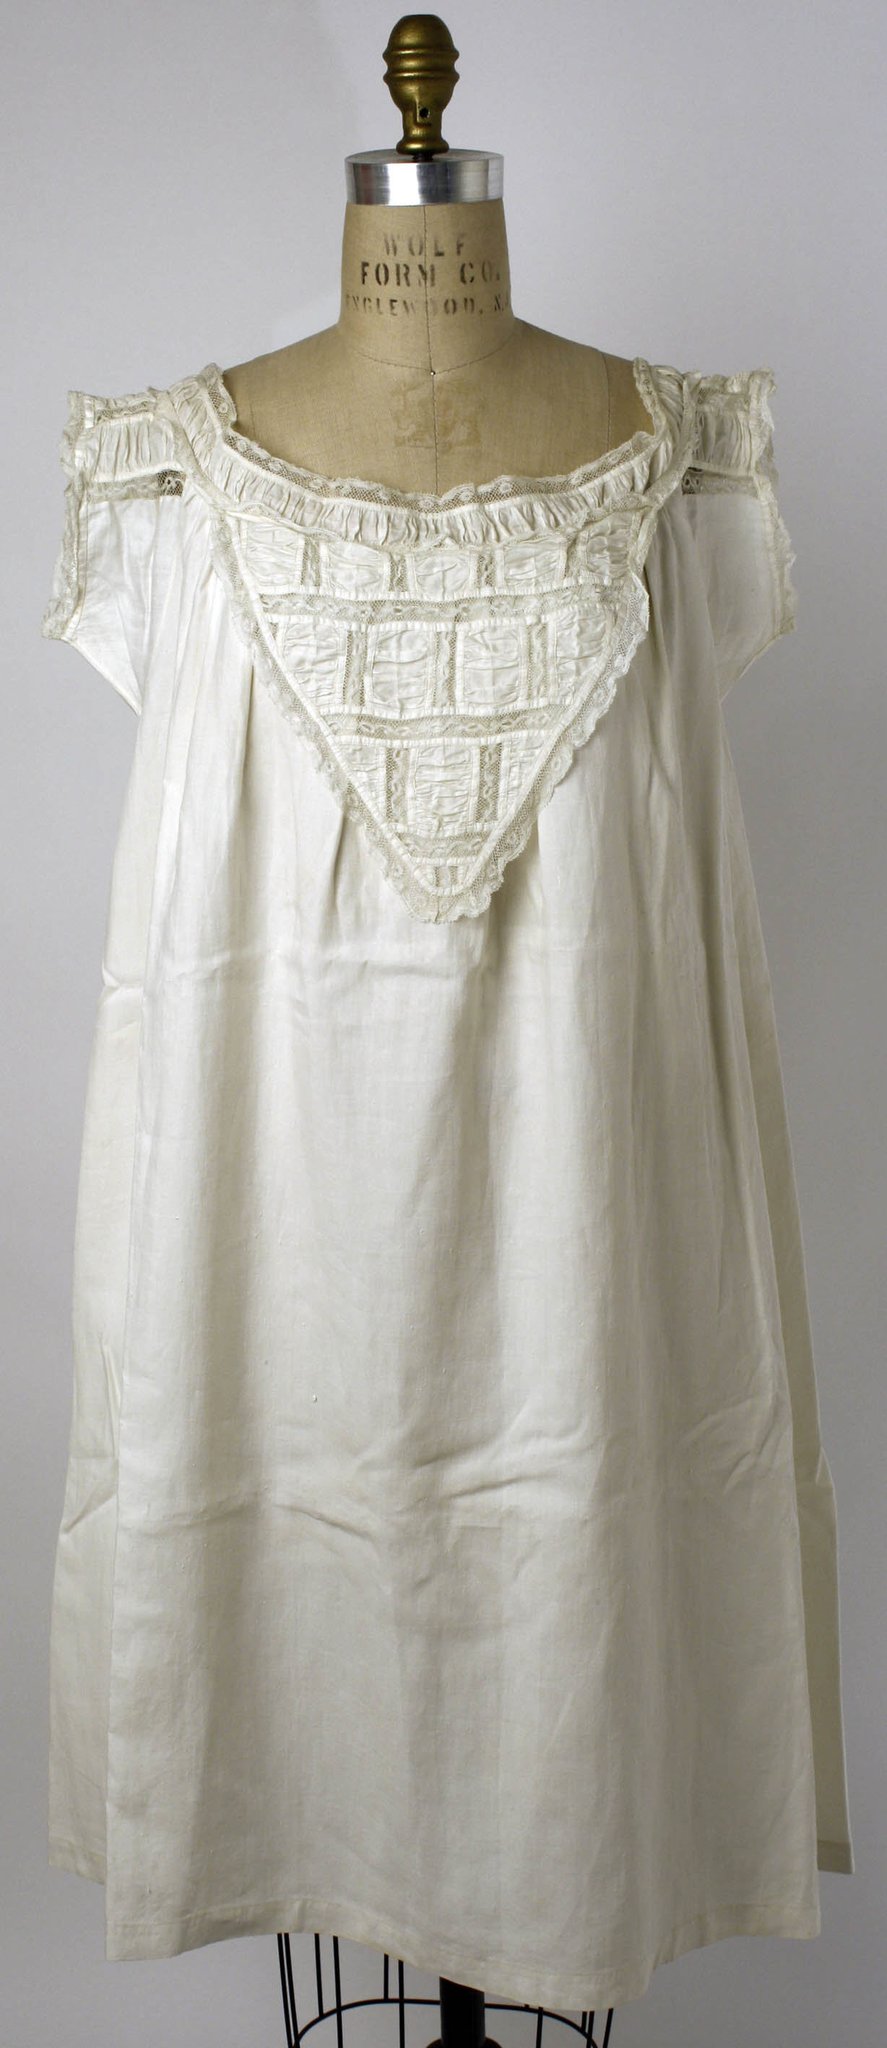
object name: chemise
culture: american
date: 1862-1867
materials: cotton, linen